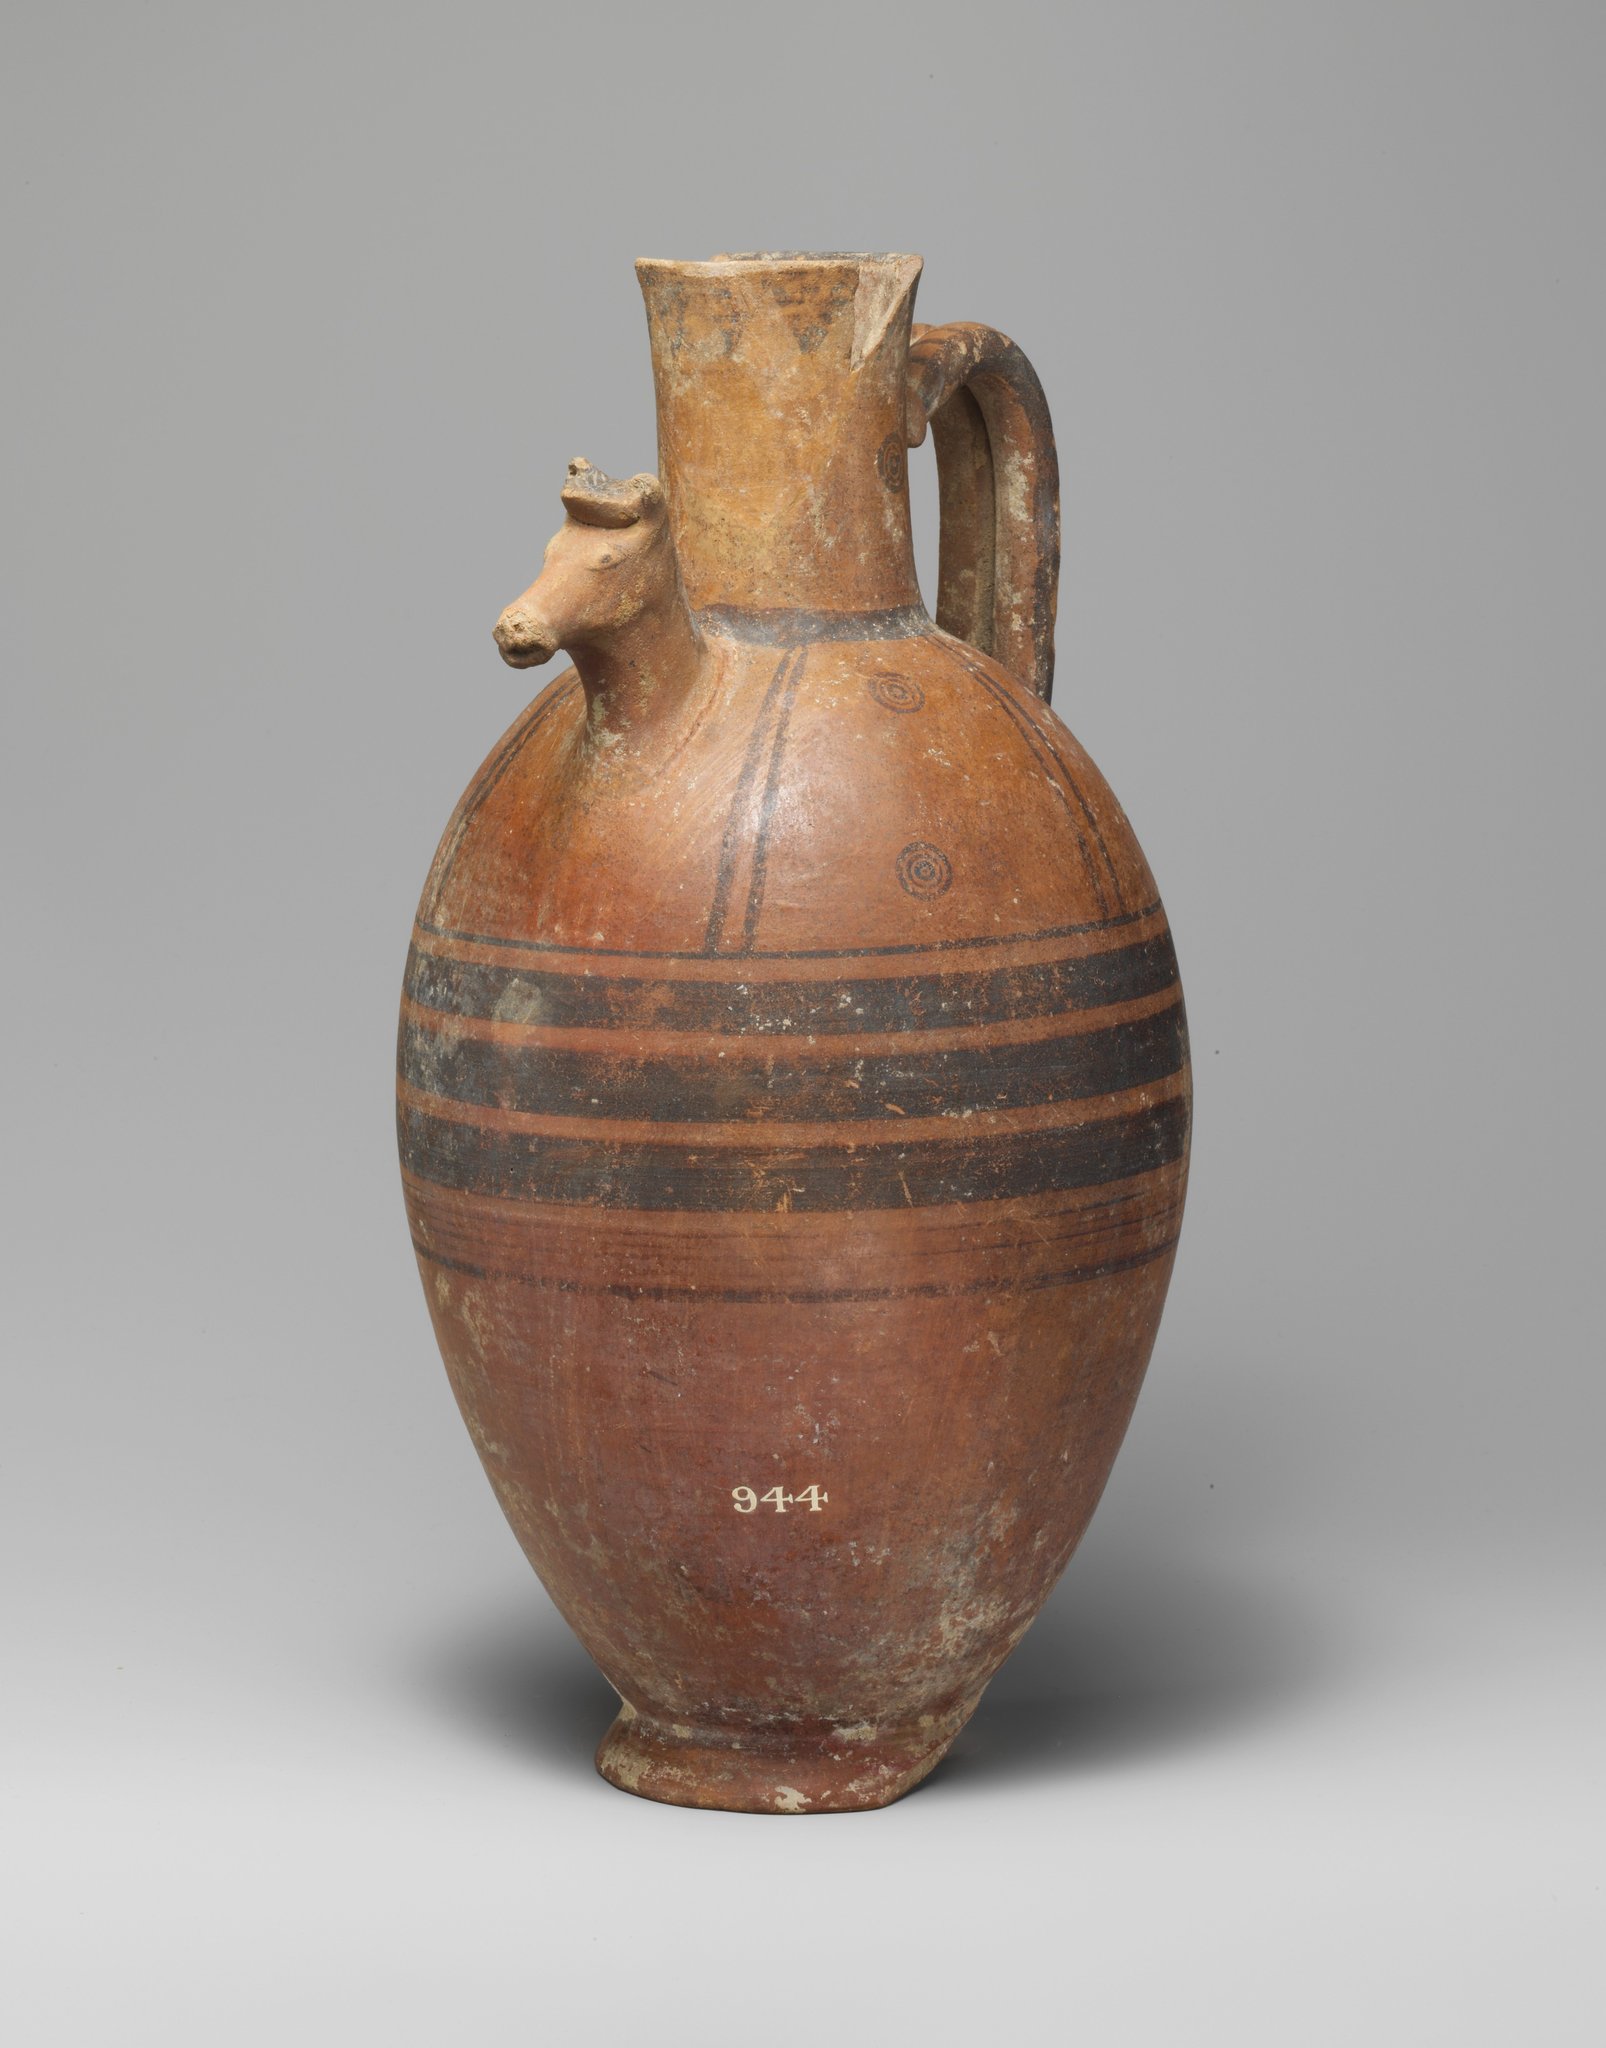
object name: jug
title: Terracotta jug with horse's head in relief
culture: cypriot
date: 480-350 BCE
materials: terracotta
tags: horses